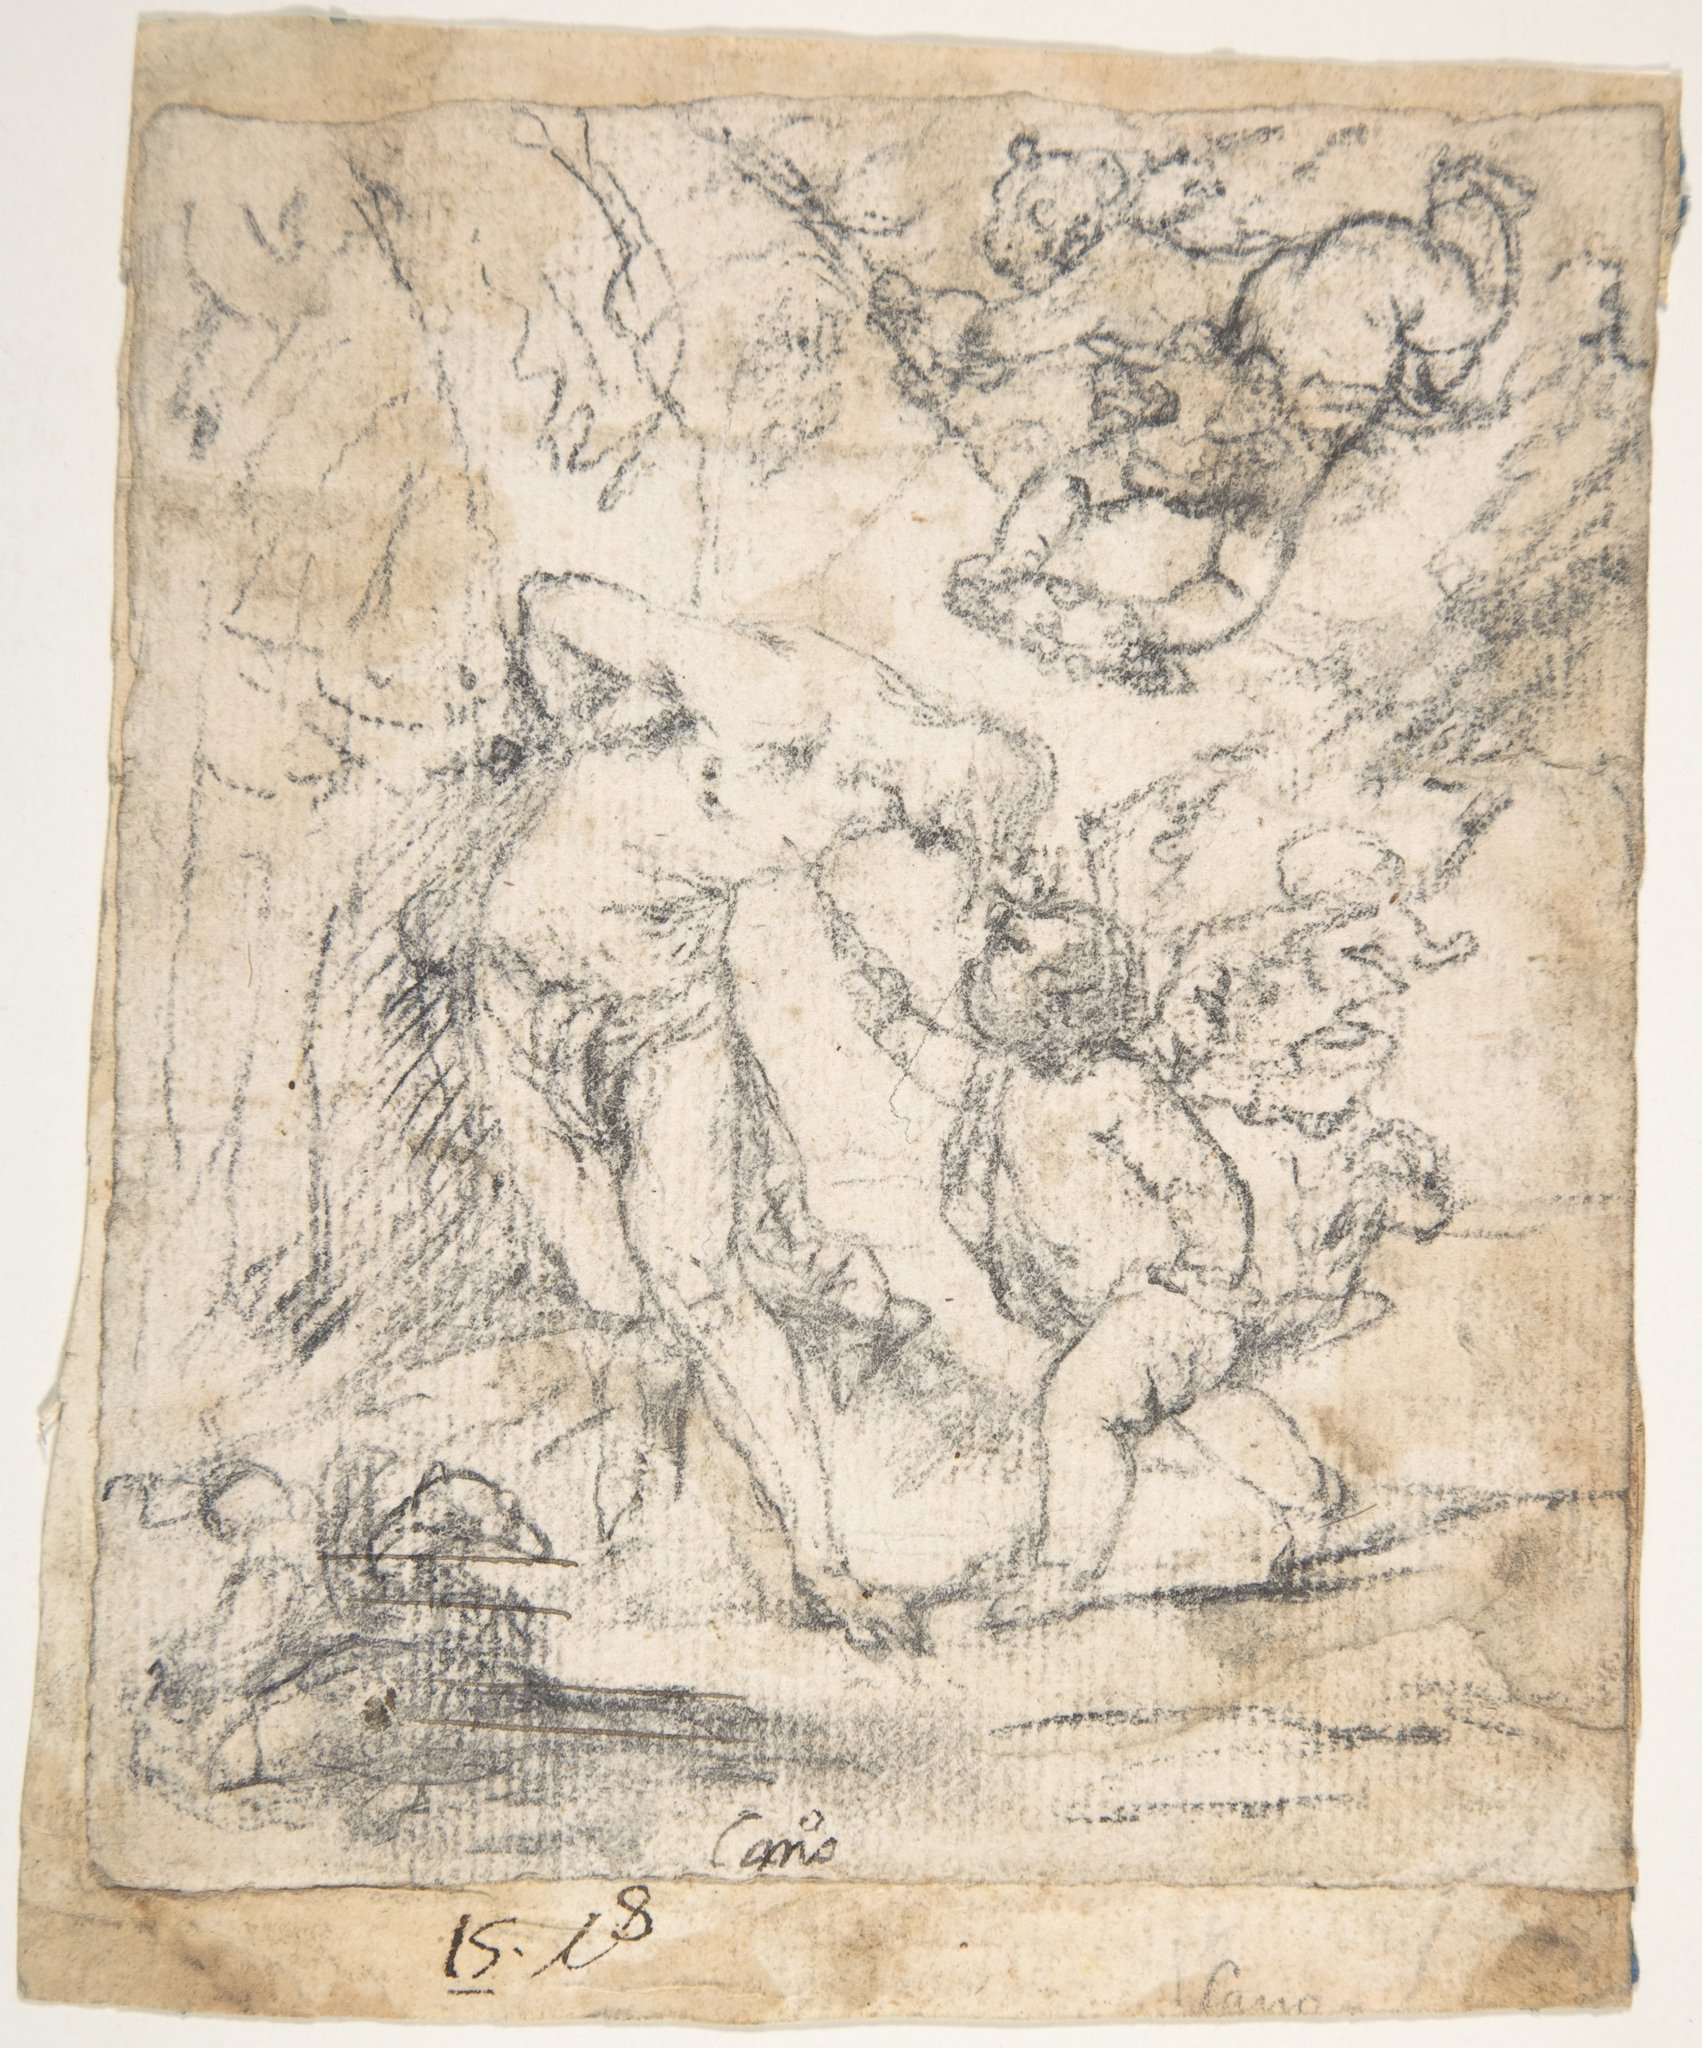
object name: drawing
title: Angels Ministering to St. Sebastian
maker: alonso cano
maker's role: artist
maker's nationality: spanish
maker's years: 1601-1667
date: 1601-1667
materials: chalk, ink, paper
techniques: pen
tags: angels,saints